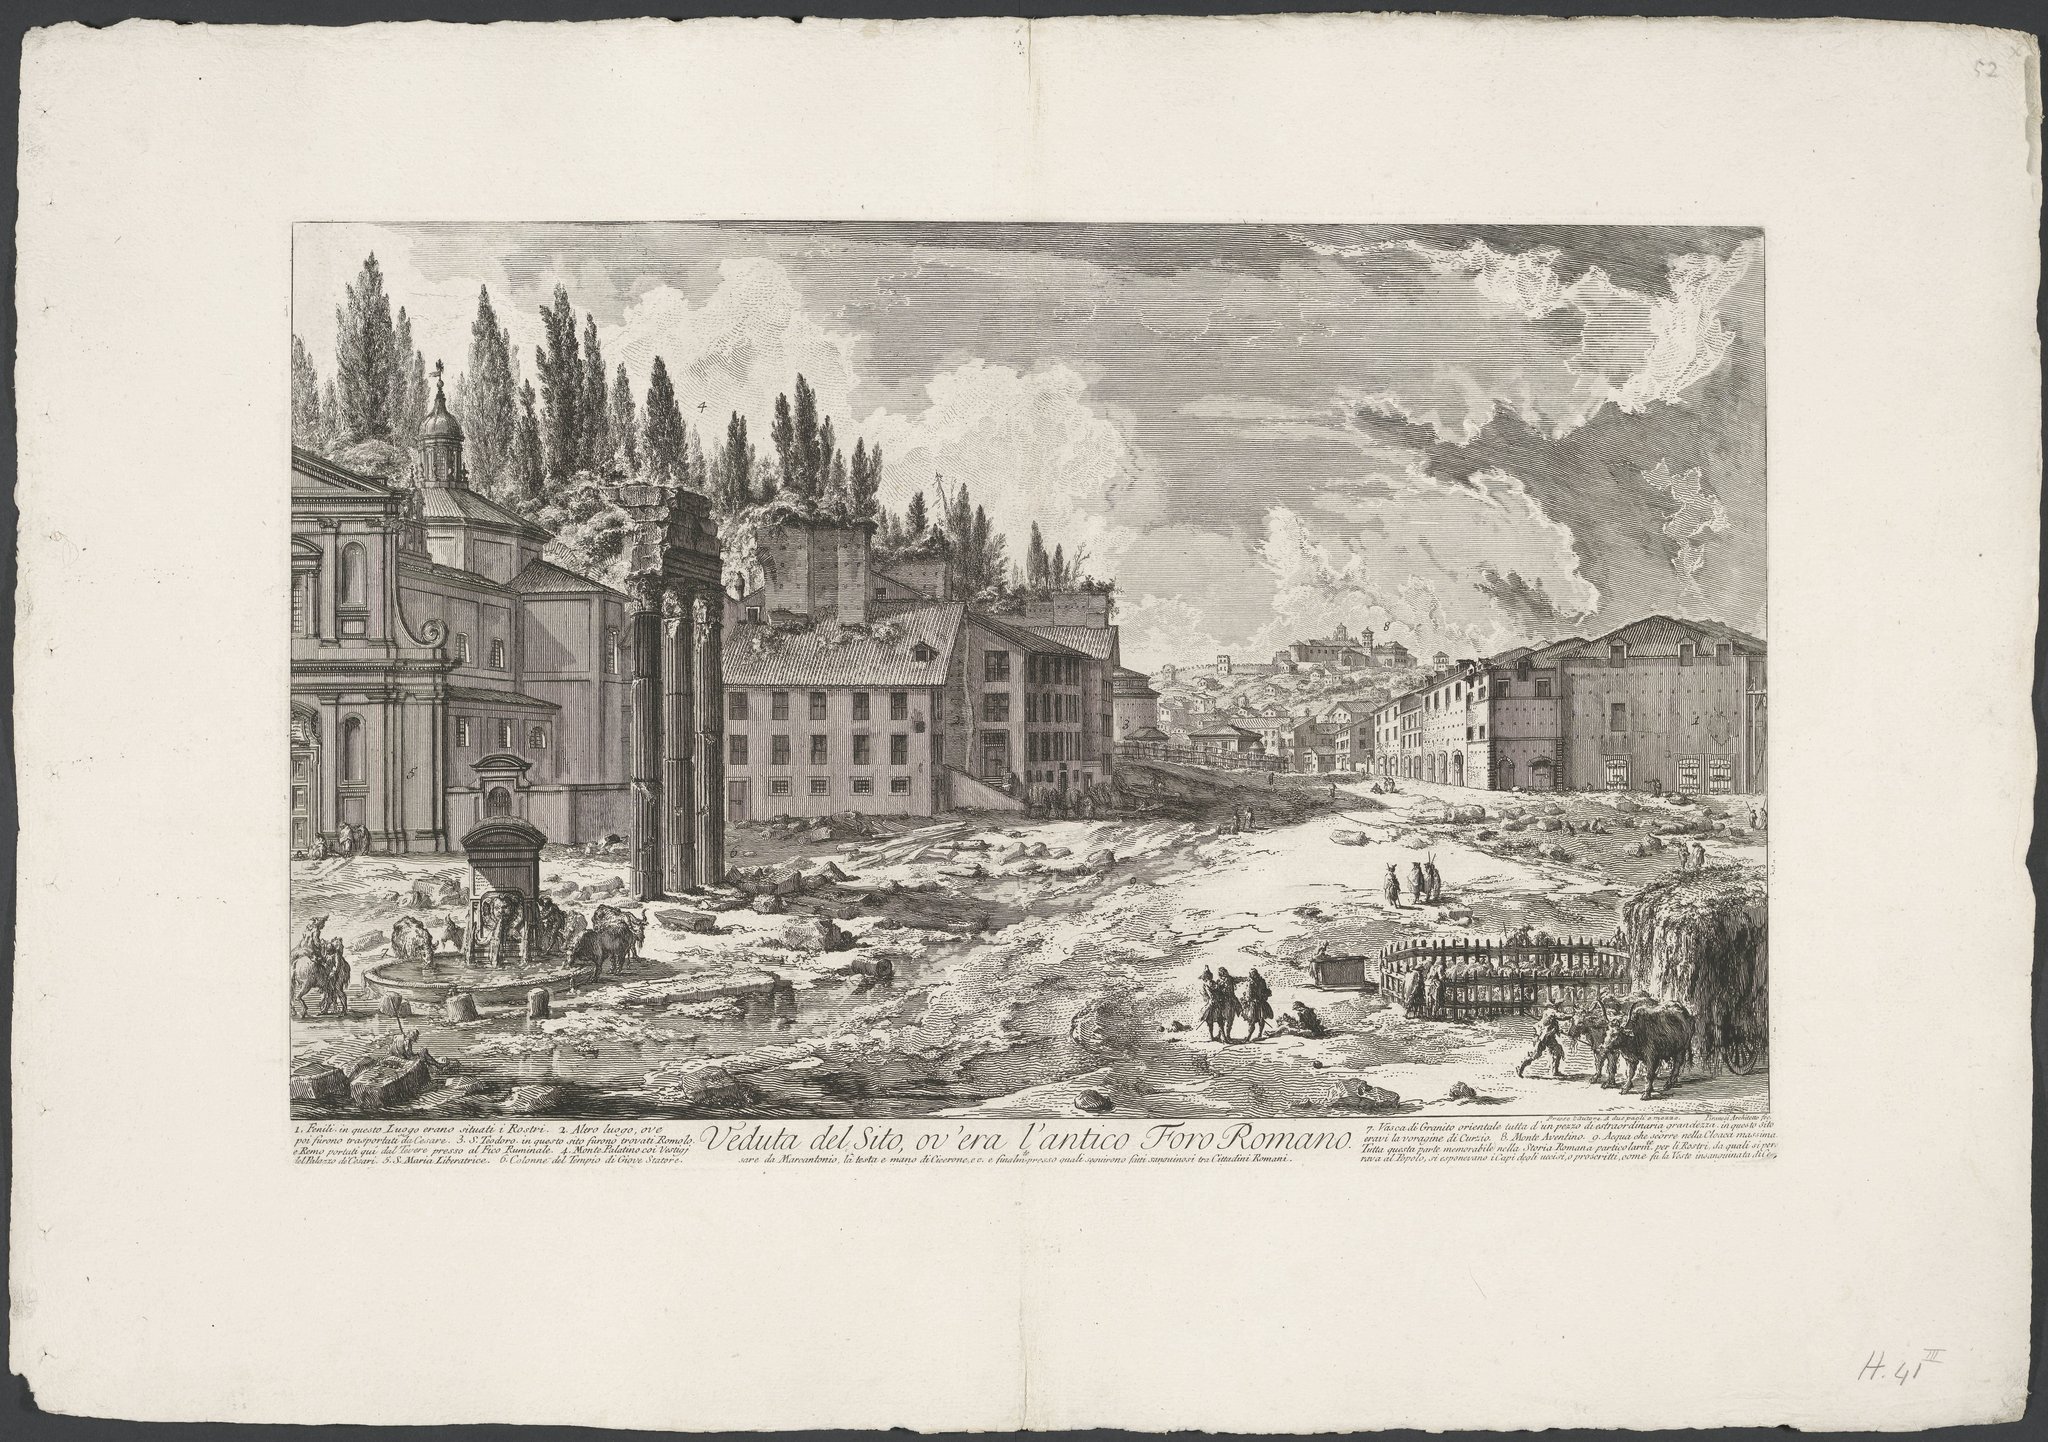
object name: print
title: Gezichten op Rome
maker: giovanni battista piranesi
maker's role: designer, draughtsman, print maker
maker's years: 1720-1778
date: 1748-1778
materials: paper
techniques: etching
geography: rome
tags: ruin of a building ~ architecture, landscape with ruins, temple, shrine ~ roman religion, rome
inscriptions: collector's mark: Lugt 2228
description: Deze prent maakt deel uit van de serie 'Vedute di Roma'. Piranesi werkte aan deze 135 platen tellende serie tussen 1748 en zijn dood in 1778. Francesco Piranesi voegde later nog twee prenten toe aan de reeks van zijn vader.